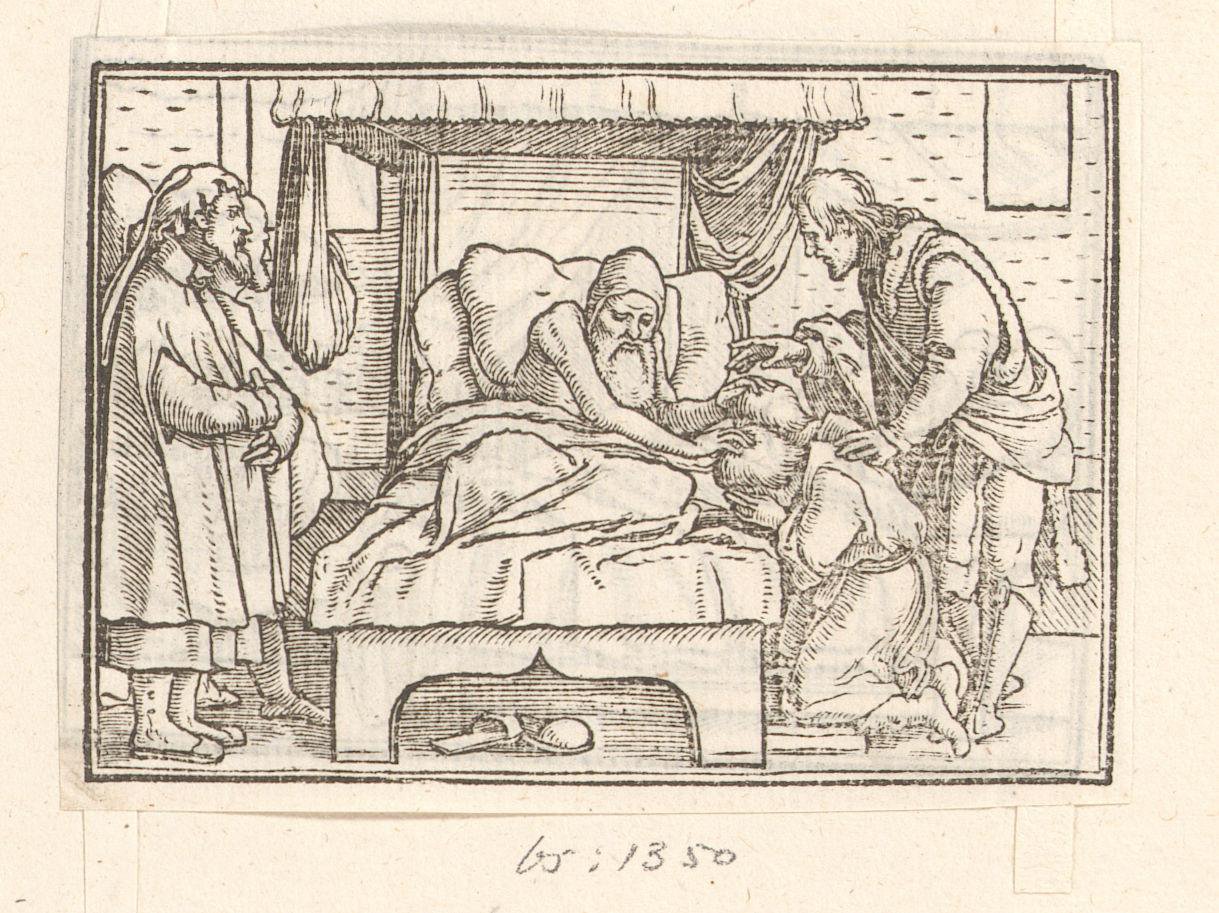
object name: book illustration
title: Geschiedenis van het Oude Testament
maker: veit rudolf specklin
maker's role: print maker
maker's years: -1550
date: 1538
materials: paper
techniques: woodcut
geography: switzerland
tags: jacob blesses manasseh and ephraim with arms uncrossed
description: Boekillustratie voor het eerst gebruikt in: Biblia Utriusque Testamenti iuxta Vulgatam Translationem, Lyon, M. en G. Trechsel (voor Hugo à Porta) 1538. Later in verschillende uitgaven opnieuw gebruikt. Deze prent vermoedelijk gebruikt in één van de uitgaven uitgegeven en/of gedrukt door Jean Frellon, Lyon.